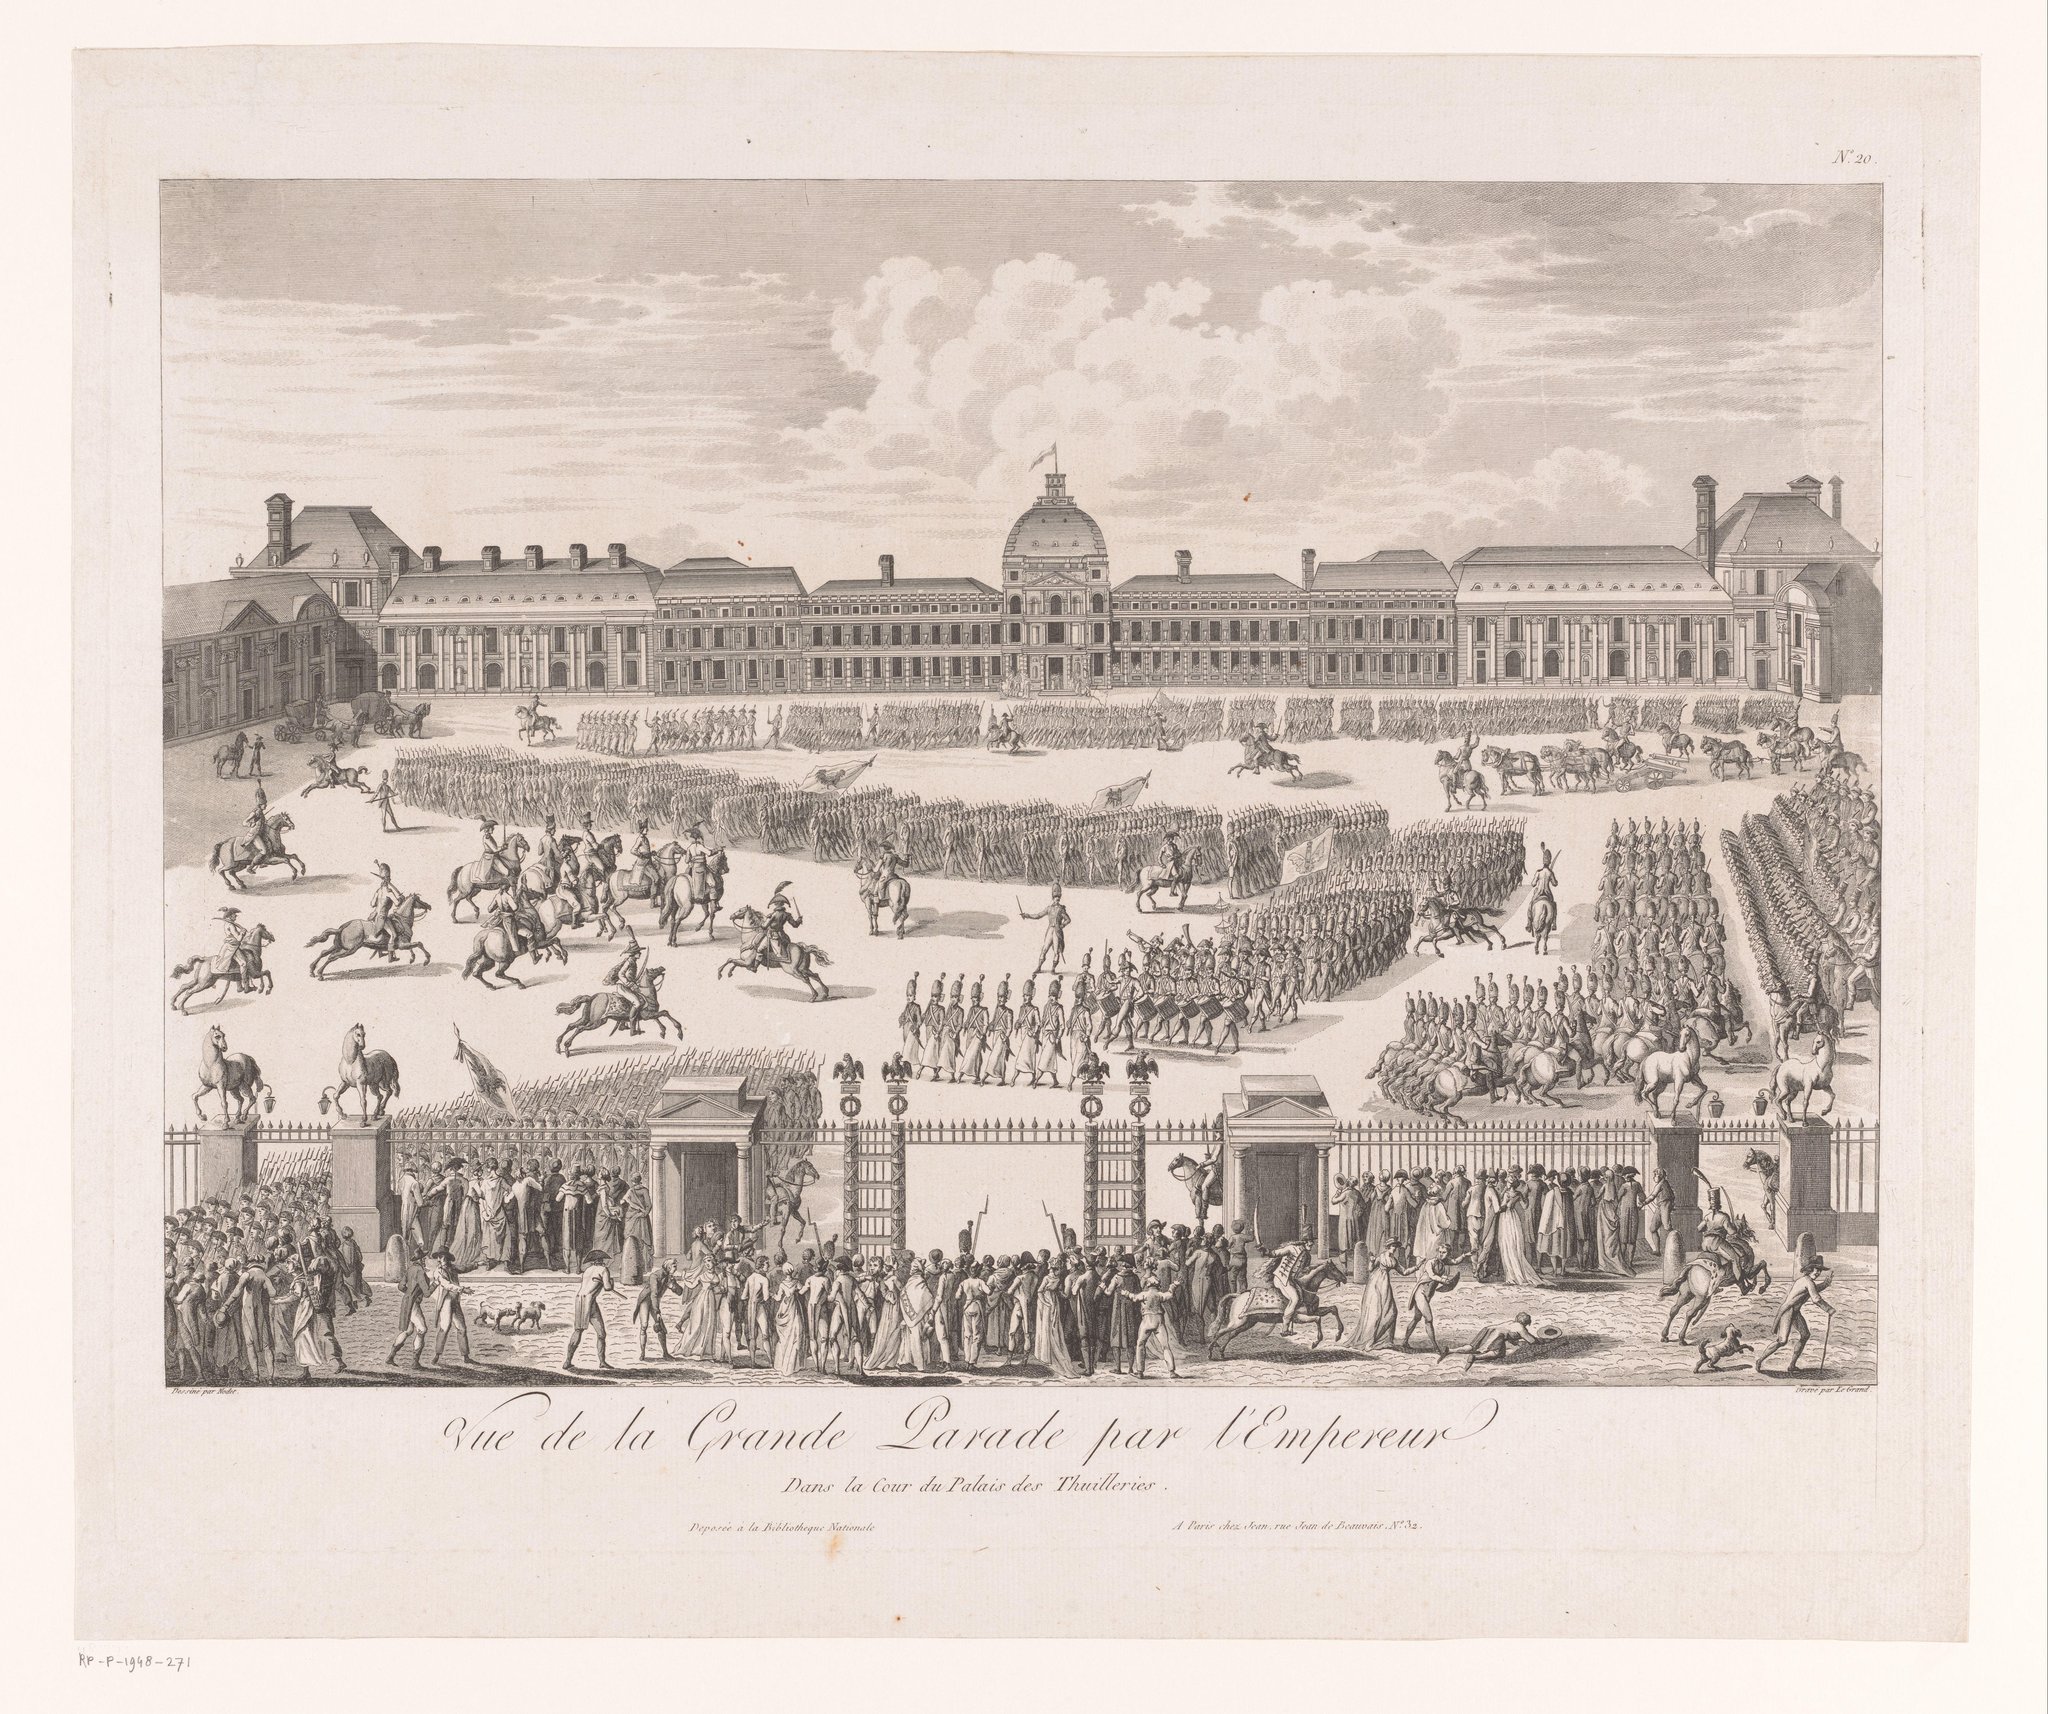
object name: print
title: Vue de la Grande Parade par l'Empereur dans la Cour du Palais des Tuileries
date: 1775-1815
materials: paper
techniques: etching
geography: france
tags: palace, military parade, pageant, tuileries palace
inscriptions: : ‘Déposé à la Bibliothèque Nationale’, collector's mark: Lugt 2228